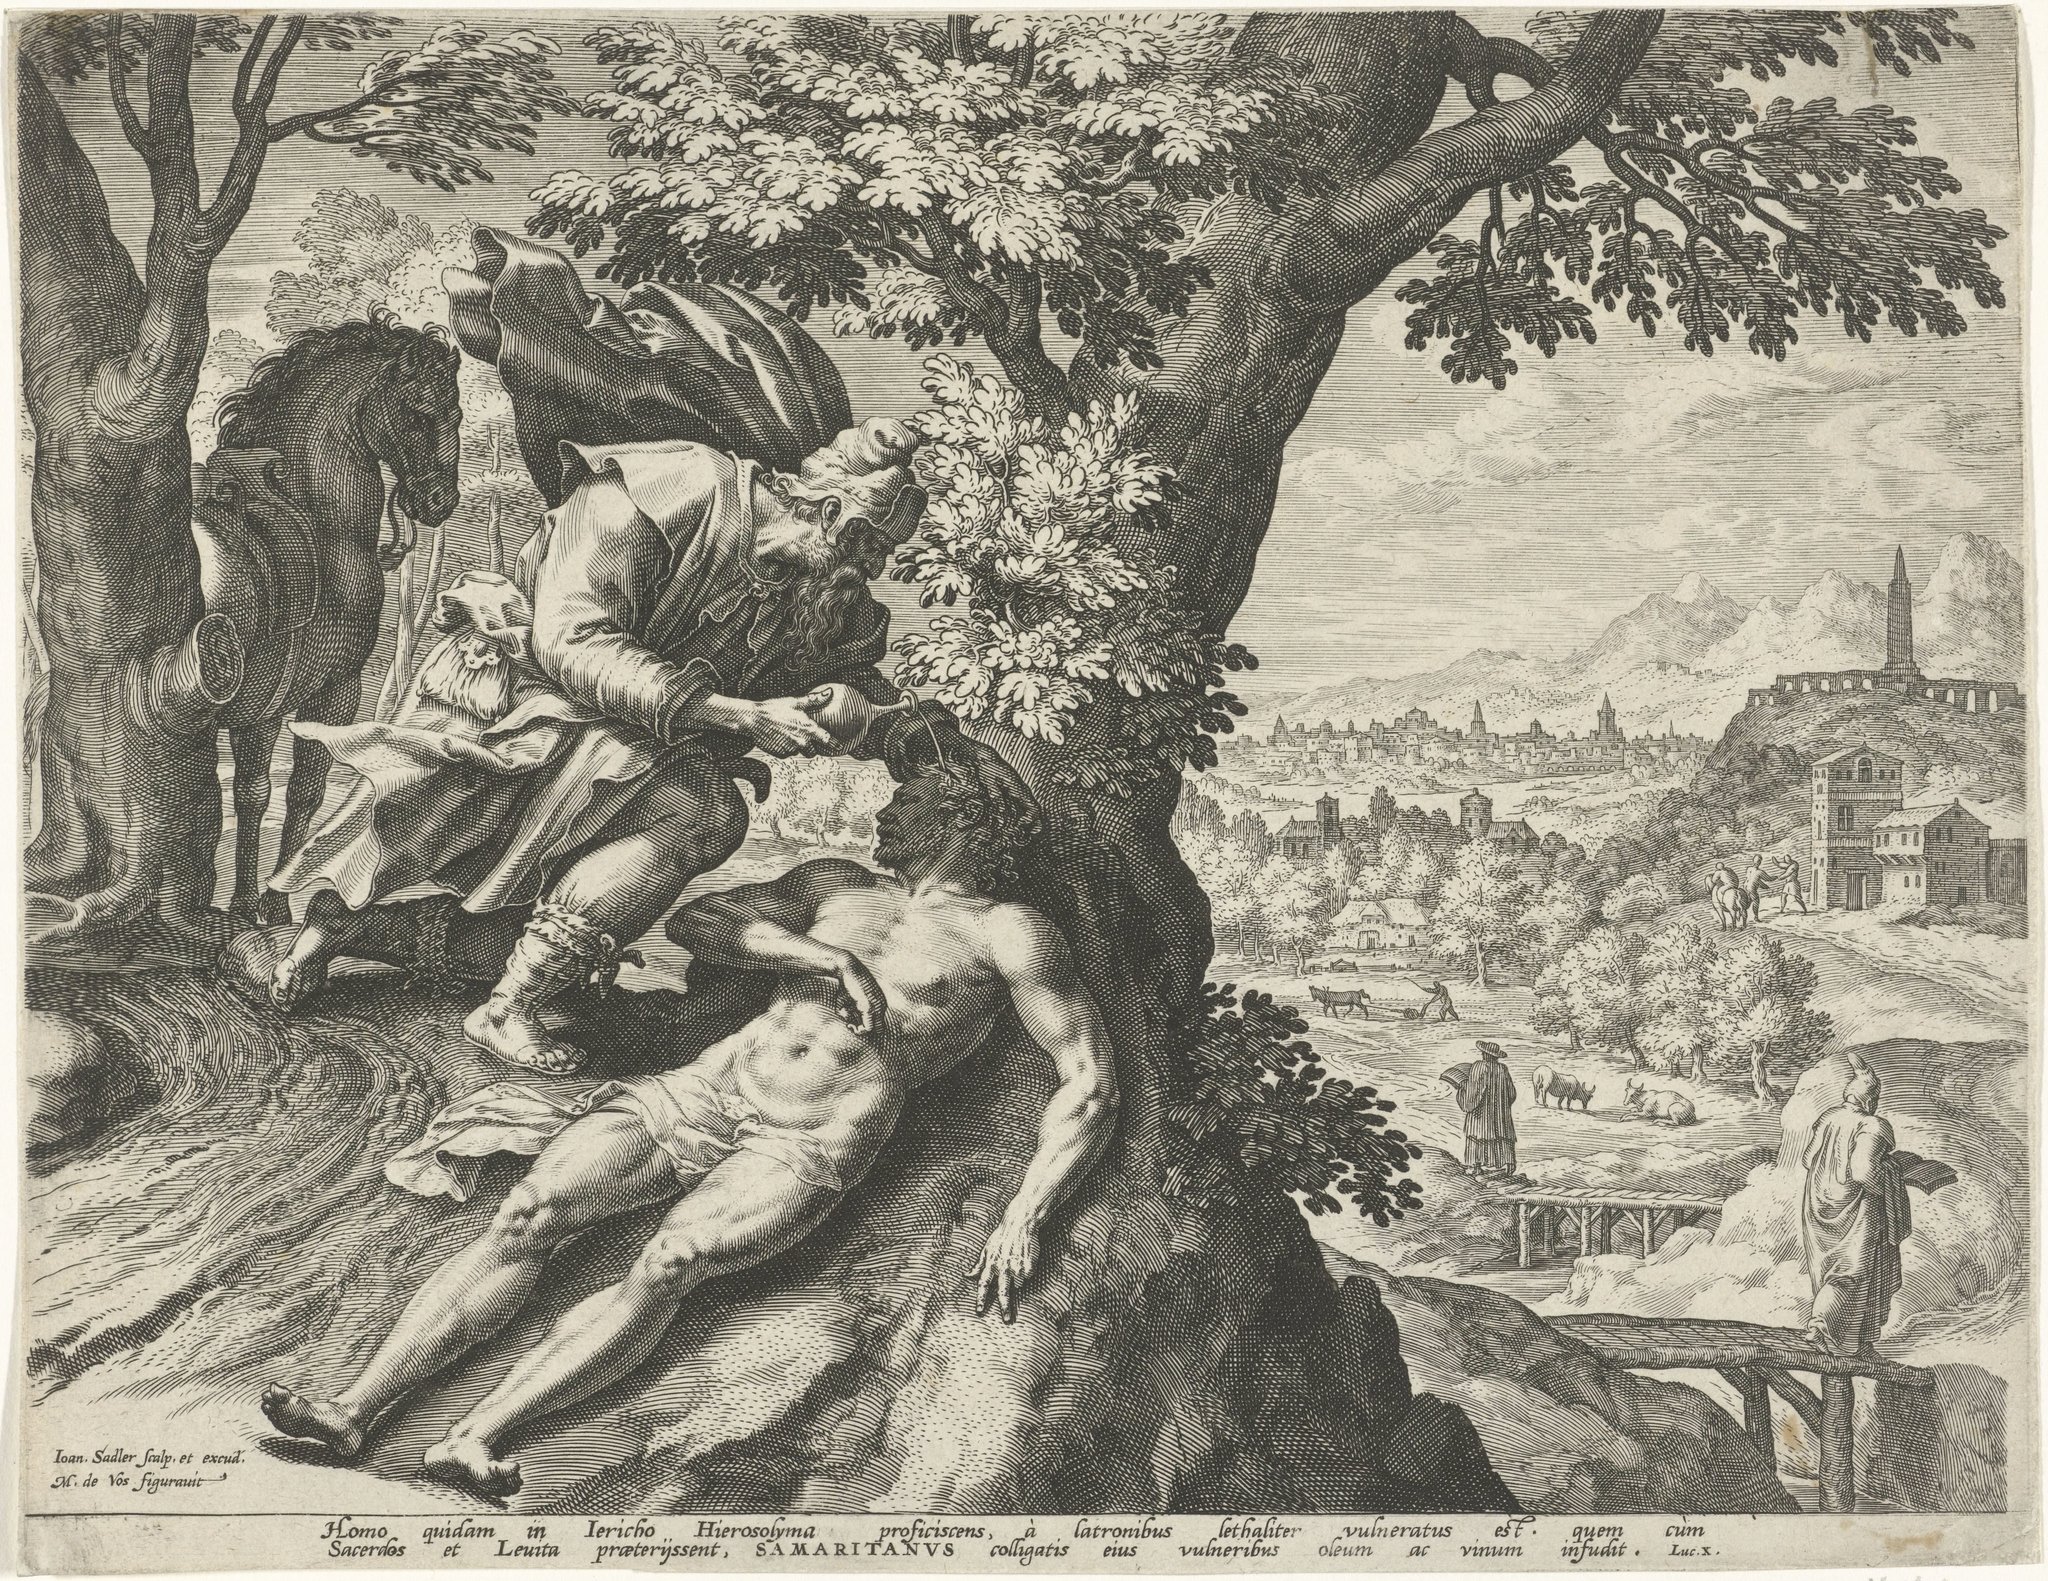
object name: print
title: Parabel van de Barmhartige Samaritaan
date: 1560-1600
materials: paper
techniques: engraving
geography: antwerp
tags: the good samaritan (luke 10:30-37)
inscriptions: collector's mark: Lugt 240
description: Landschap met de uitbeelding van de parabel van de Barmhartige Samaritaan. Op de voorgrond verzorgt de barmhartige Samaritaan de gewonde reiziger. Op de achtergrond de Leviet en de priester die de reiziger aan zijn lot overlieten. In de verte de herberg waar de Samaritaan de reiziger achterlaat.